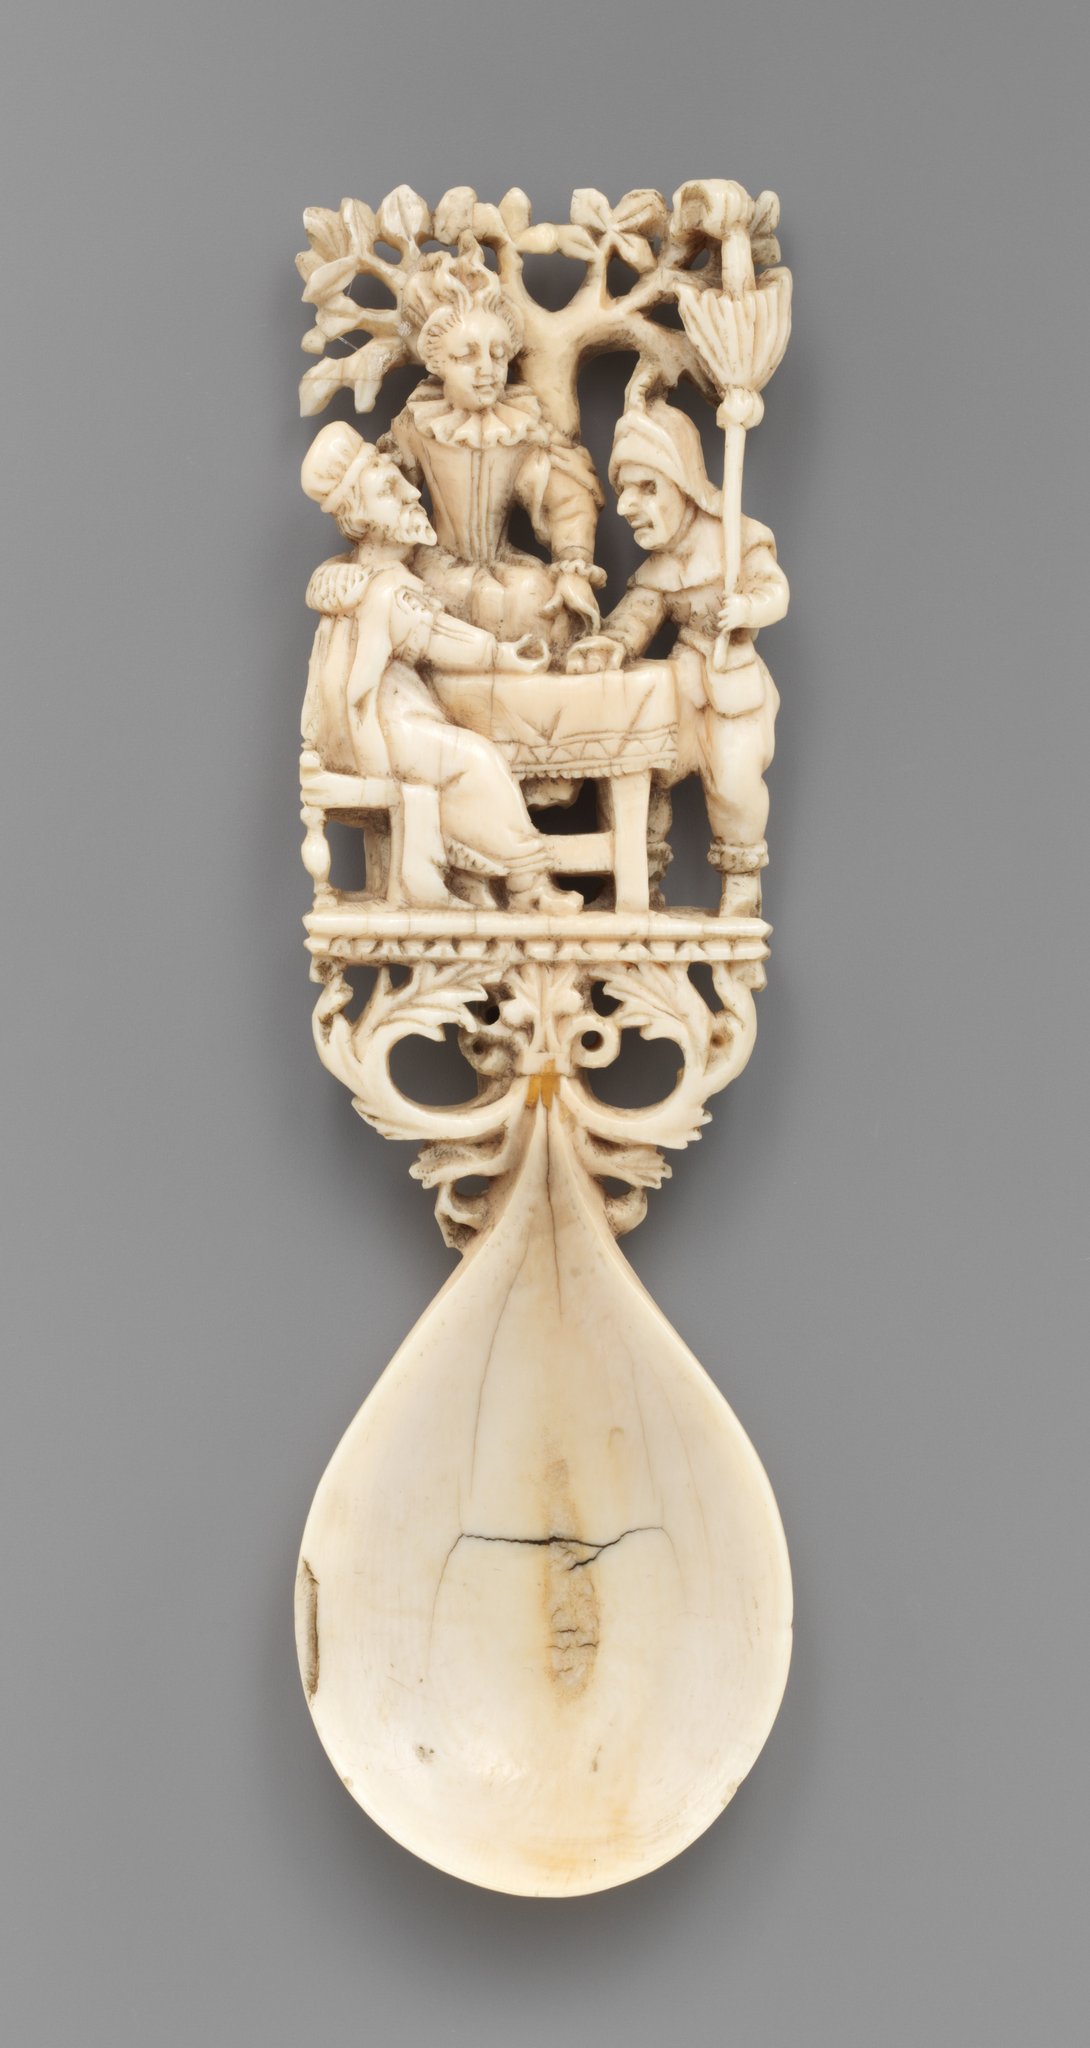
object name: spoon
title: Contemporary gaming scene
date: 1601-1633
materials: ivory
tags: men,women